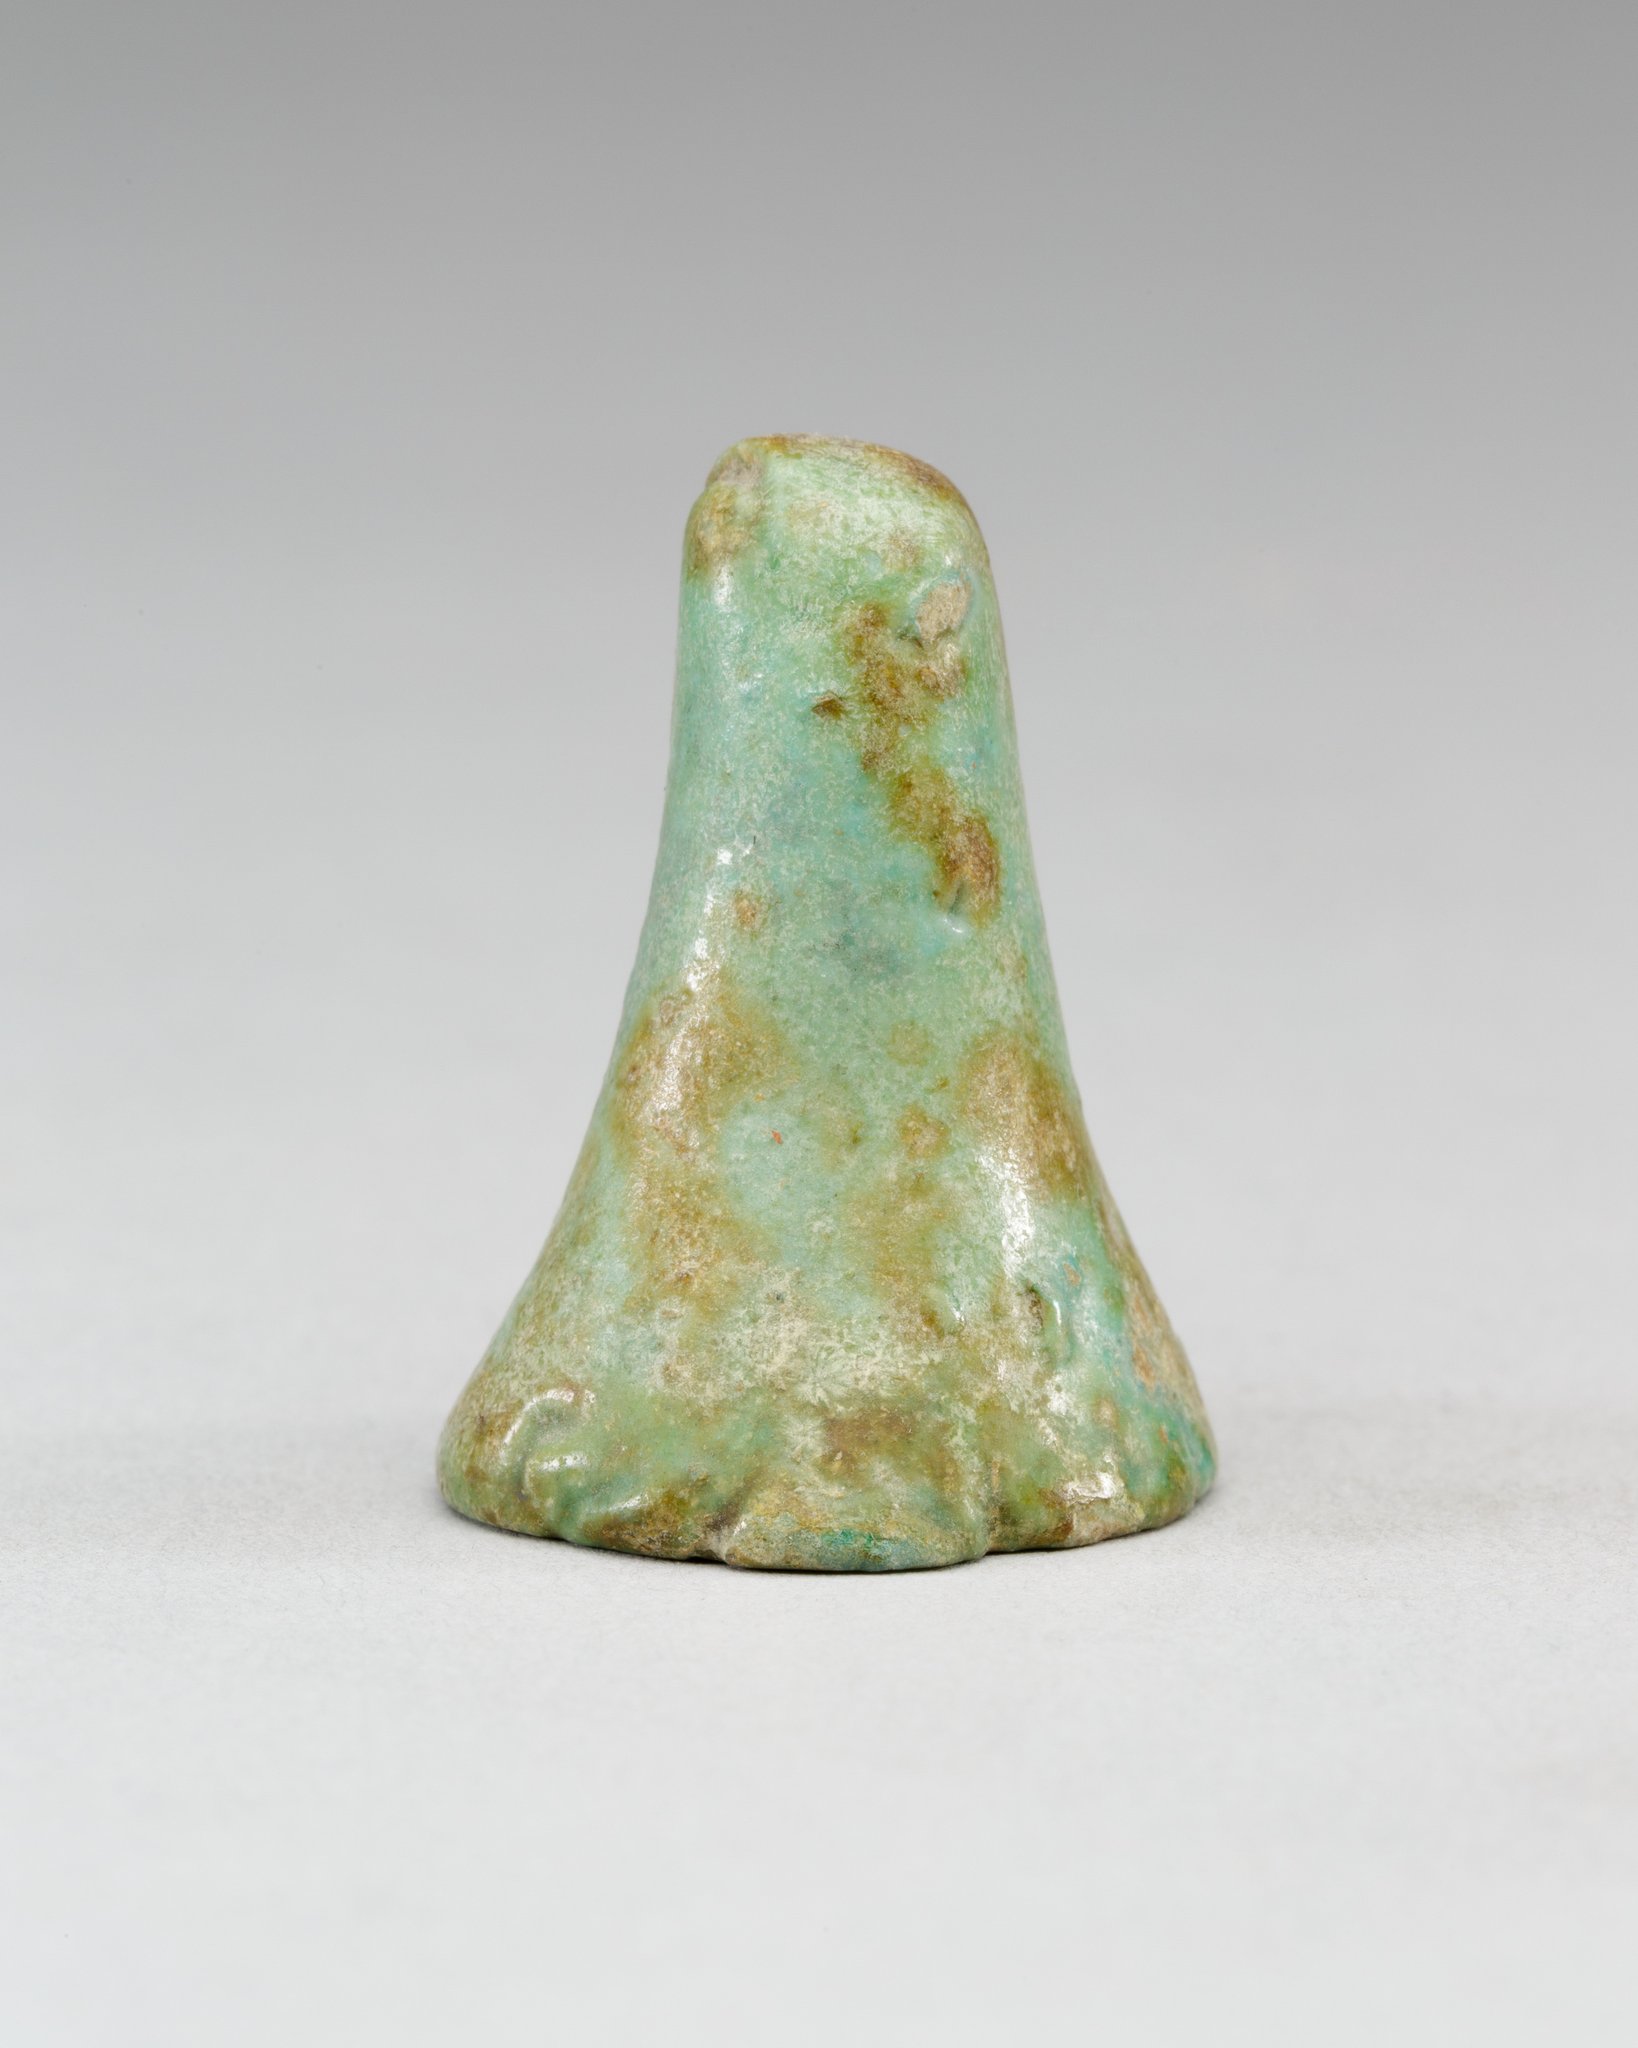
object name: game piece, conical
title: Conical Game Piece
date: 1504-1447 BCE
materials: faience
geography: egypt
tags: games